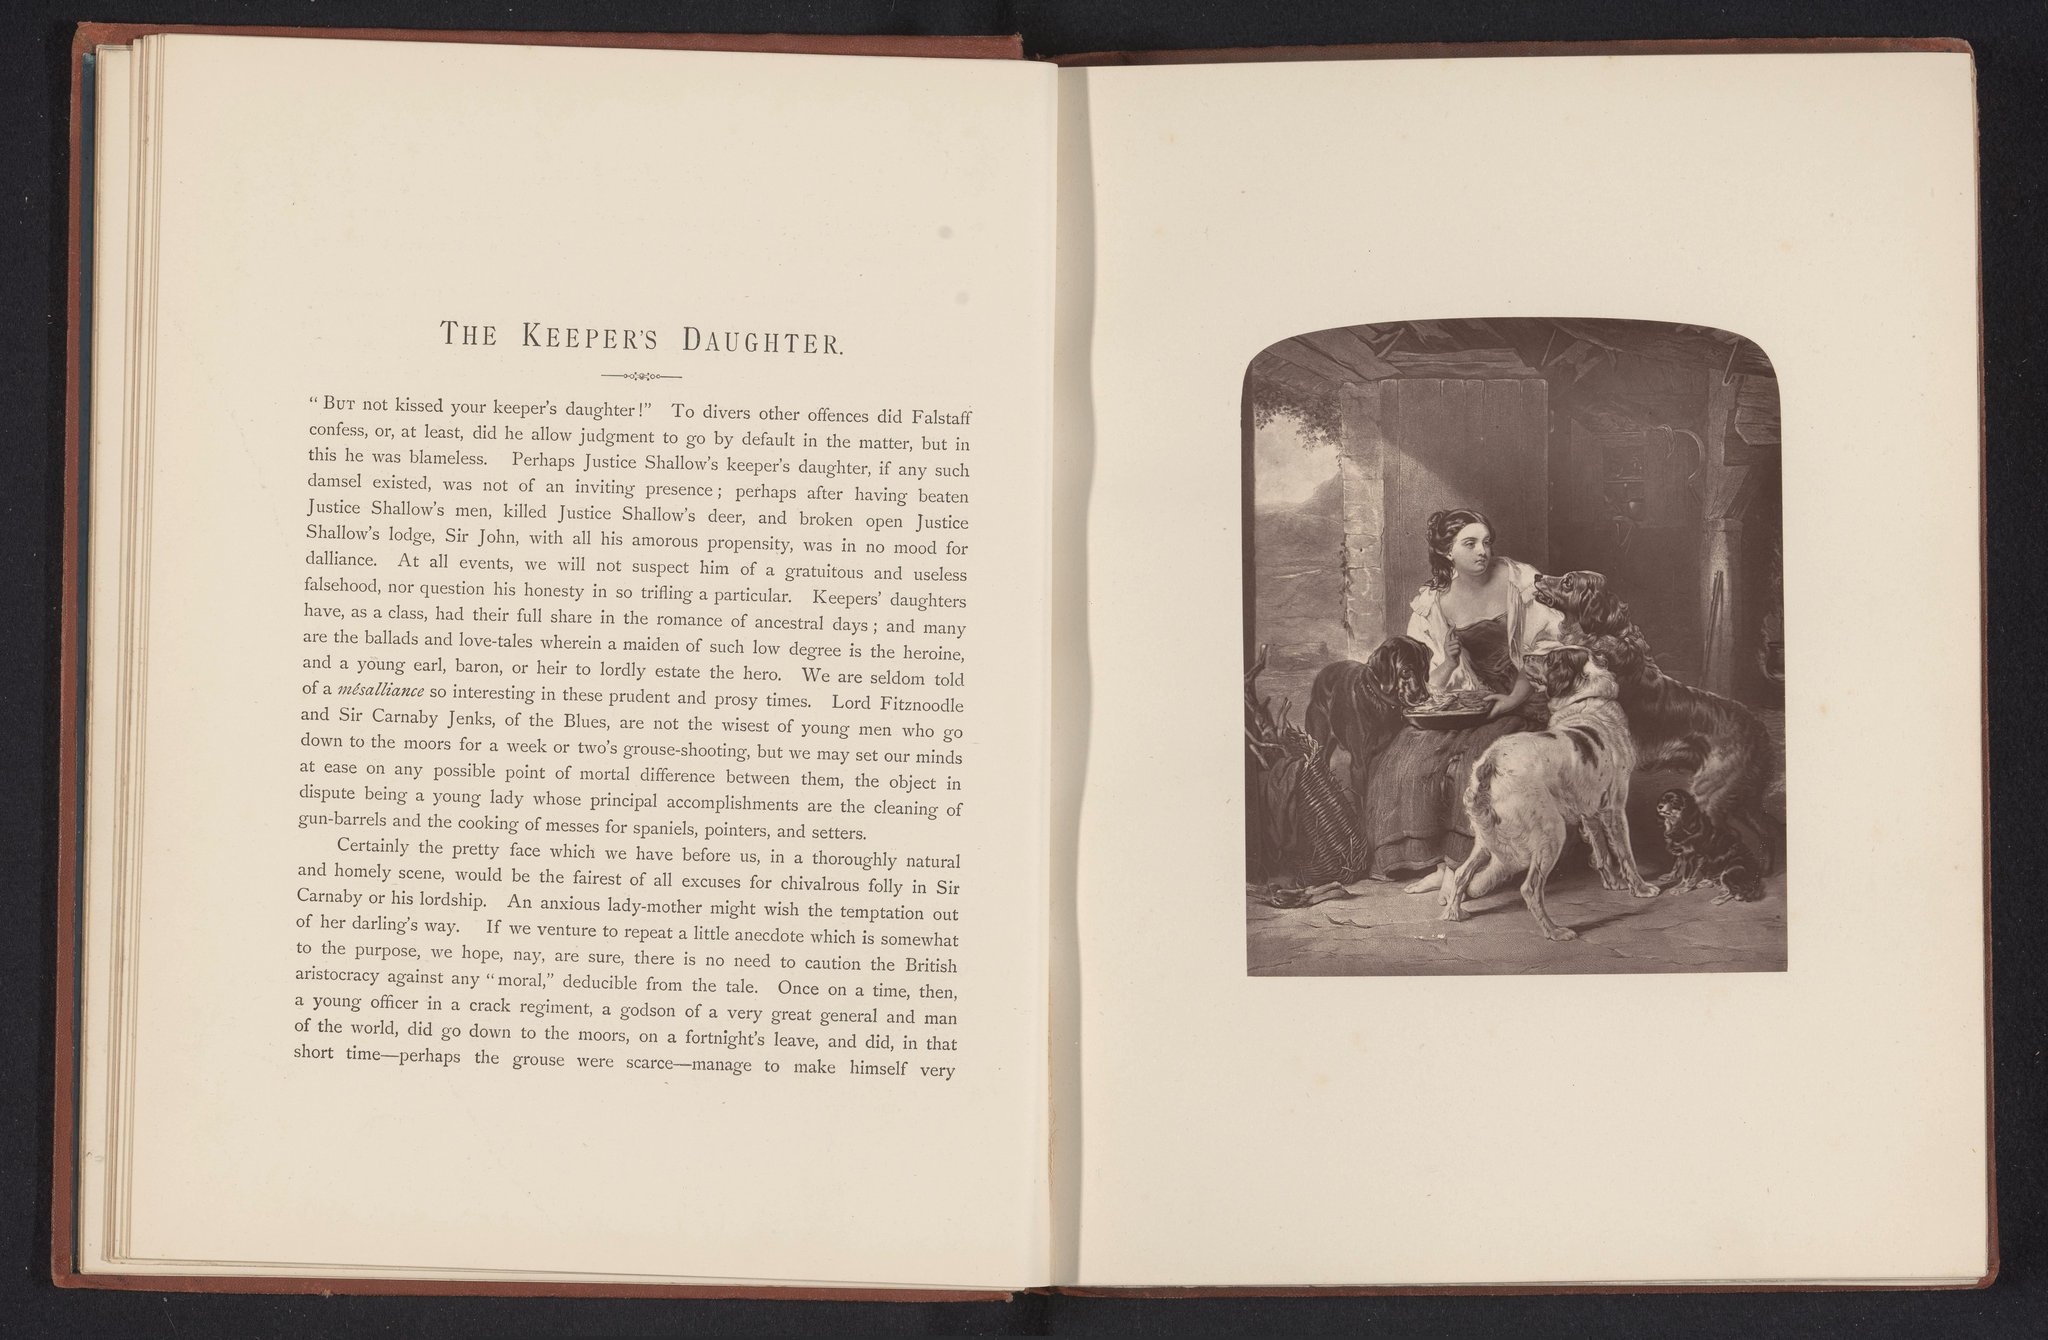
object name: photomechanical print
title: Fotoreproductie van een prent naar een schilderij, voorstellende een vrouw met honden in een interieur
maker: Anonymous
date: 1861-1871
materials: paper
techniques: woodburytype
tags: adult woman, interior ~ representation of a building, dog